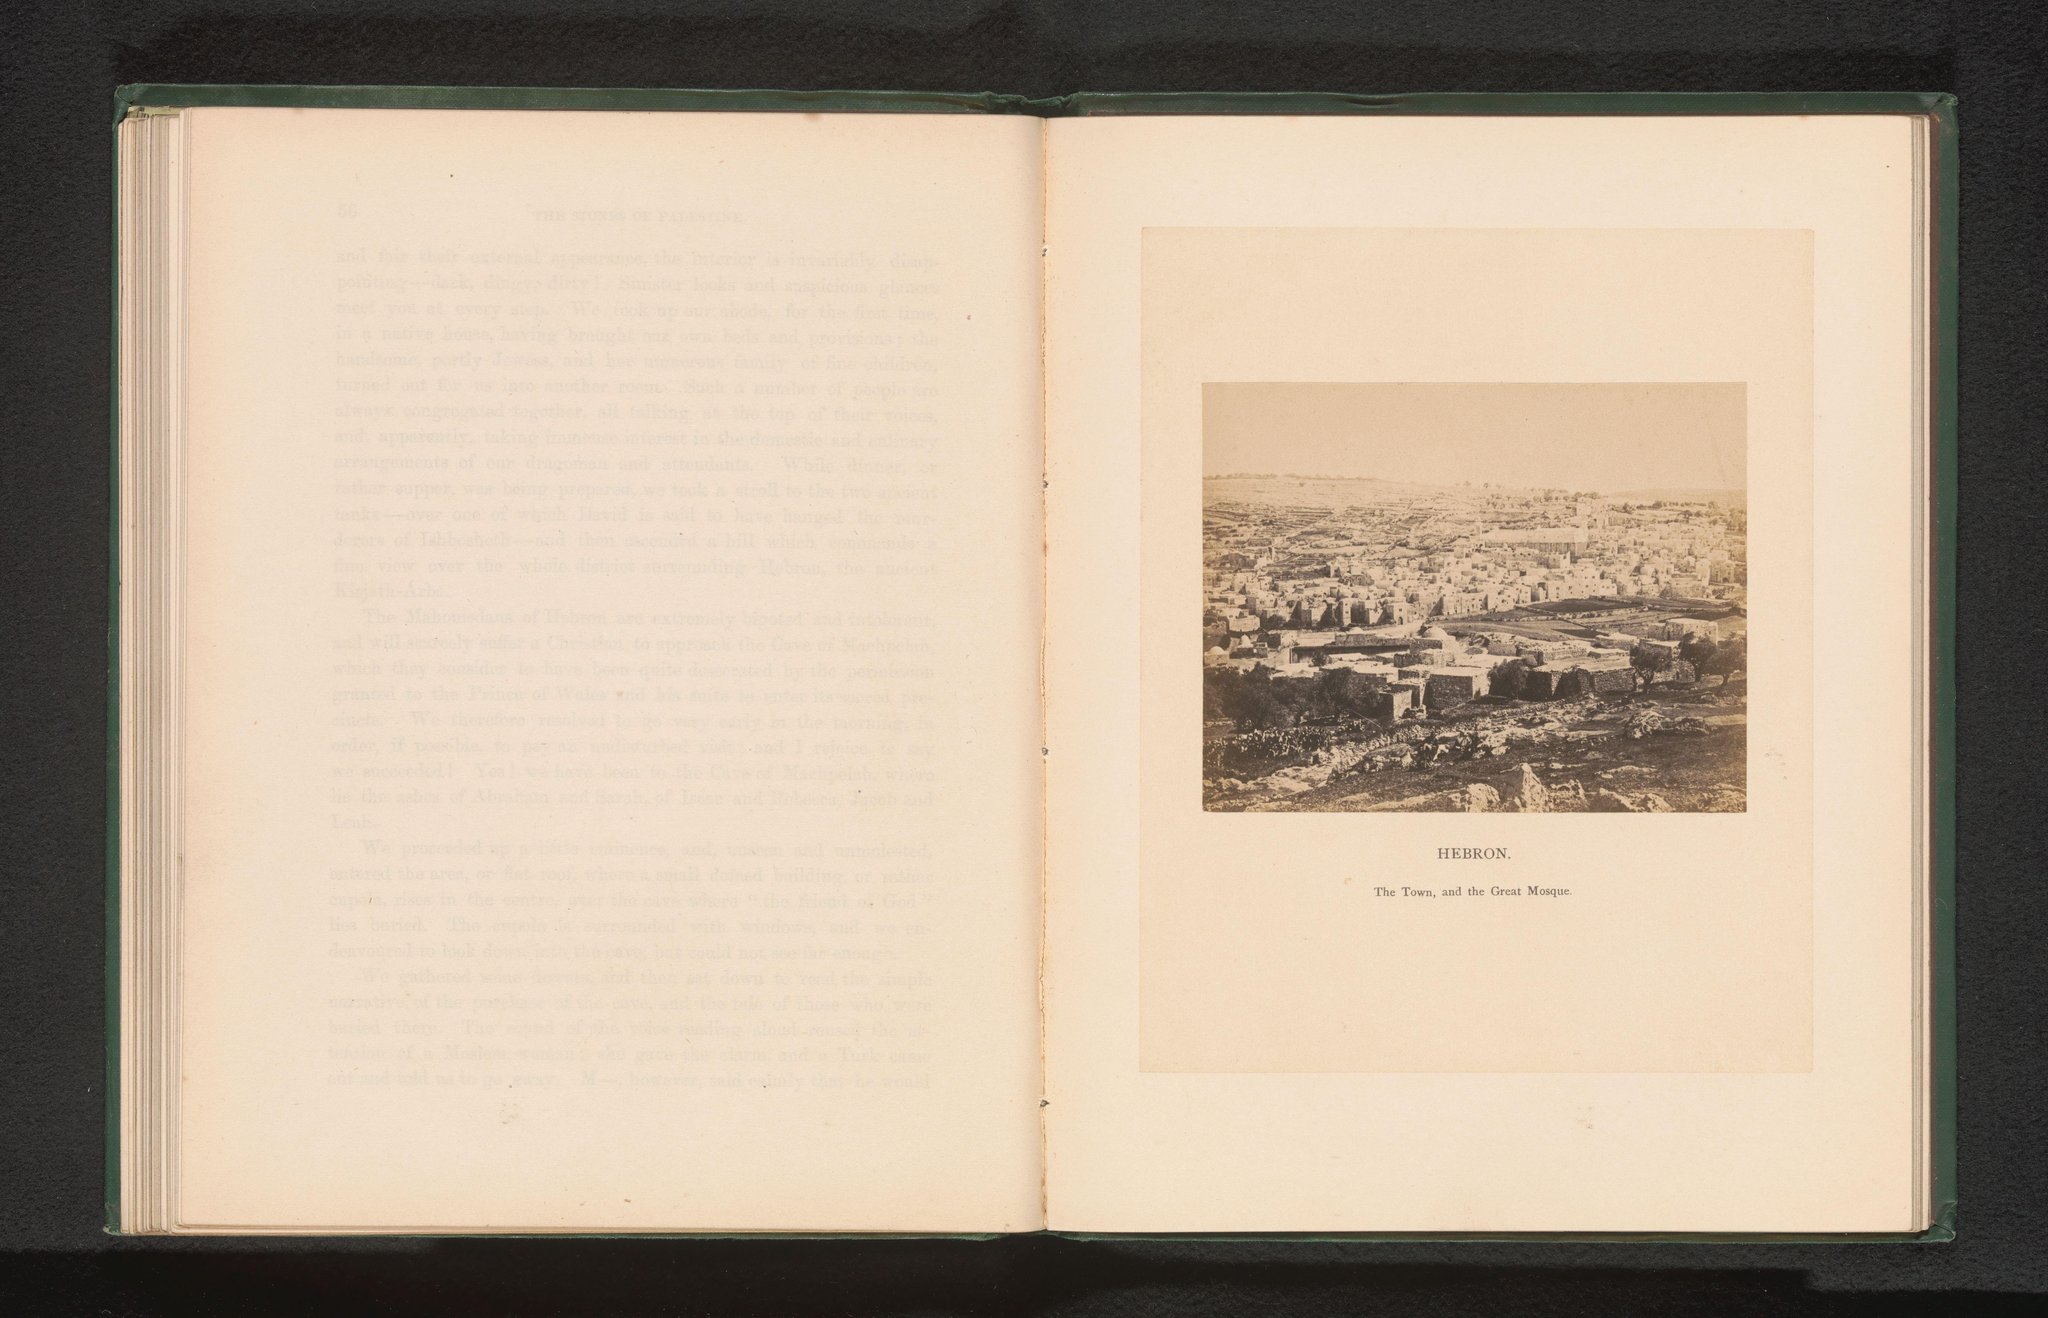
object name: photograph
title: Hebron. The town, and the Great Mosque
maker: francis bedford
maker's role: print maker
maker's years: 1815-1894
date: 1860-1865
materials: photographic support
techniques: albumen print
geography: palestine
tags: city-view in general; 'veduta'